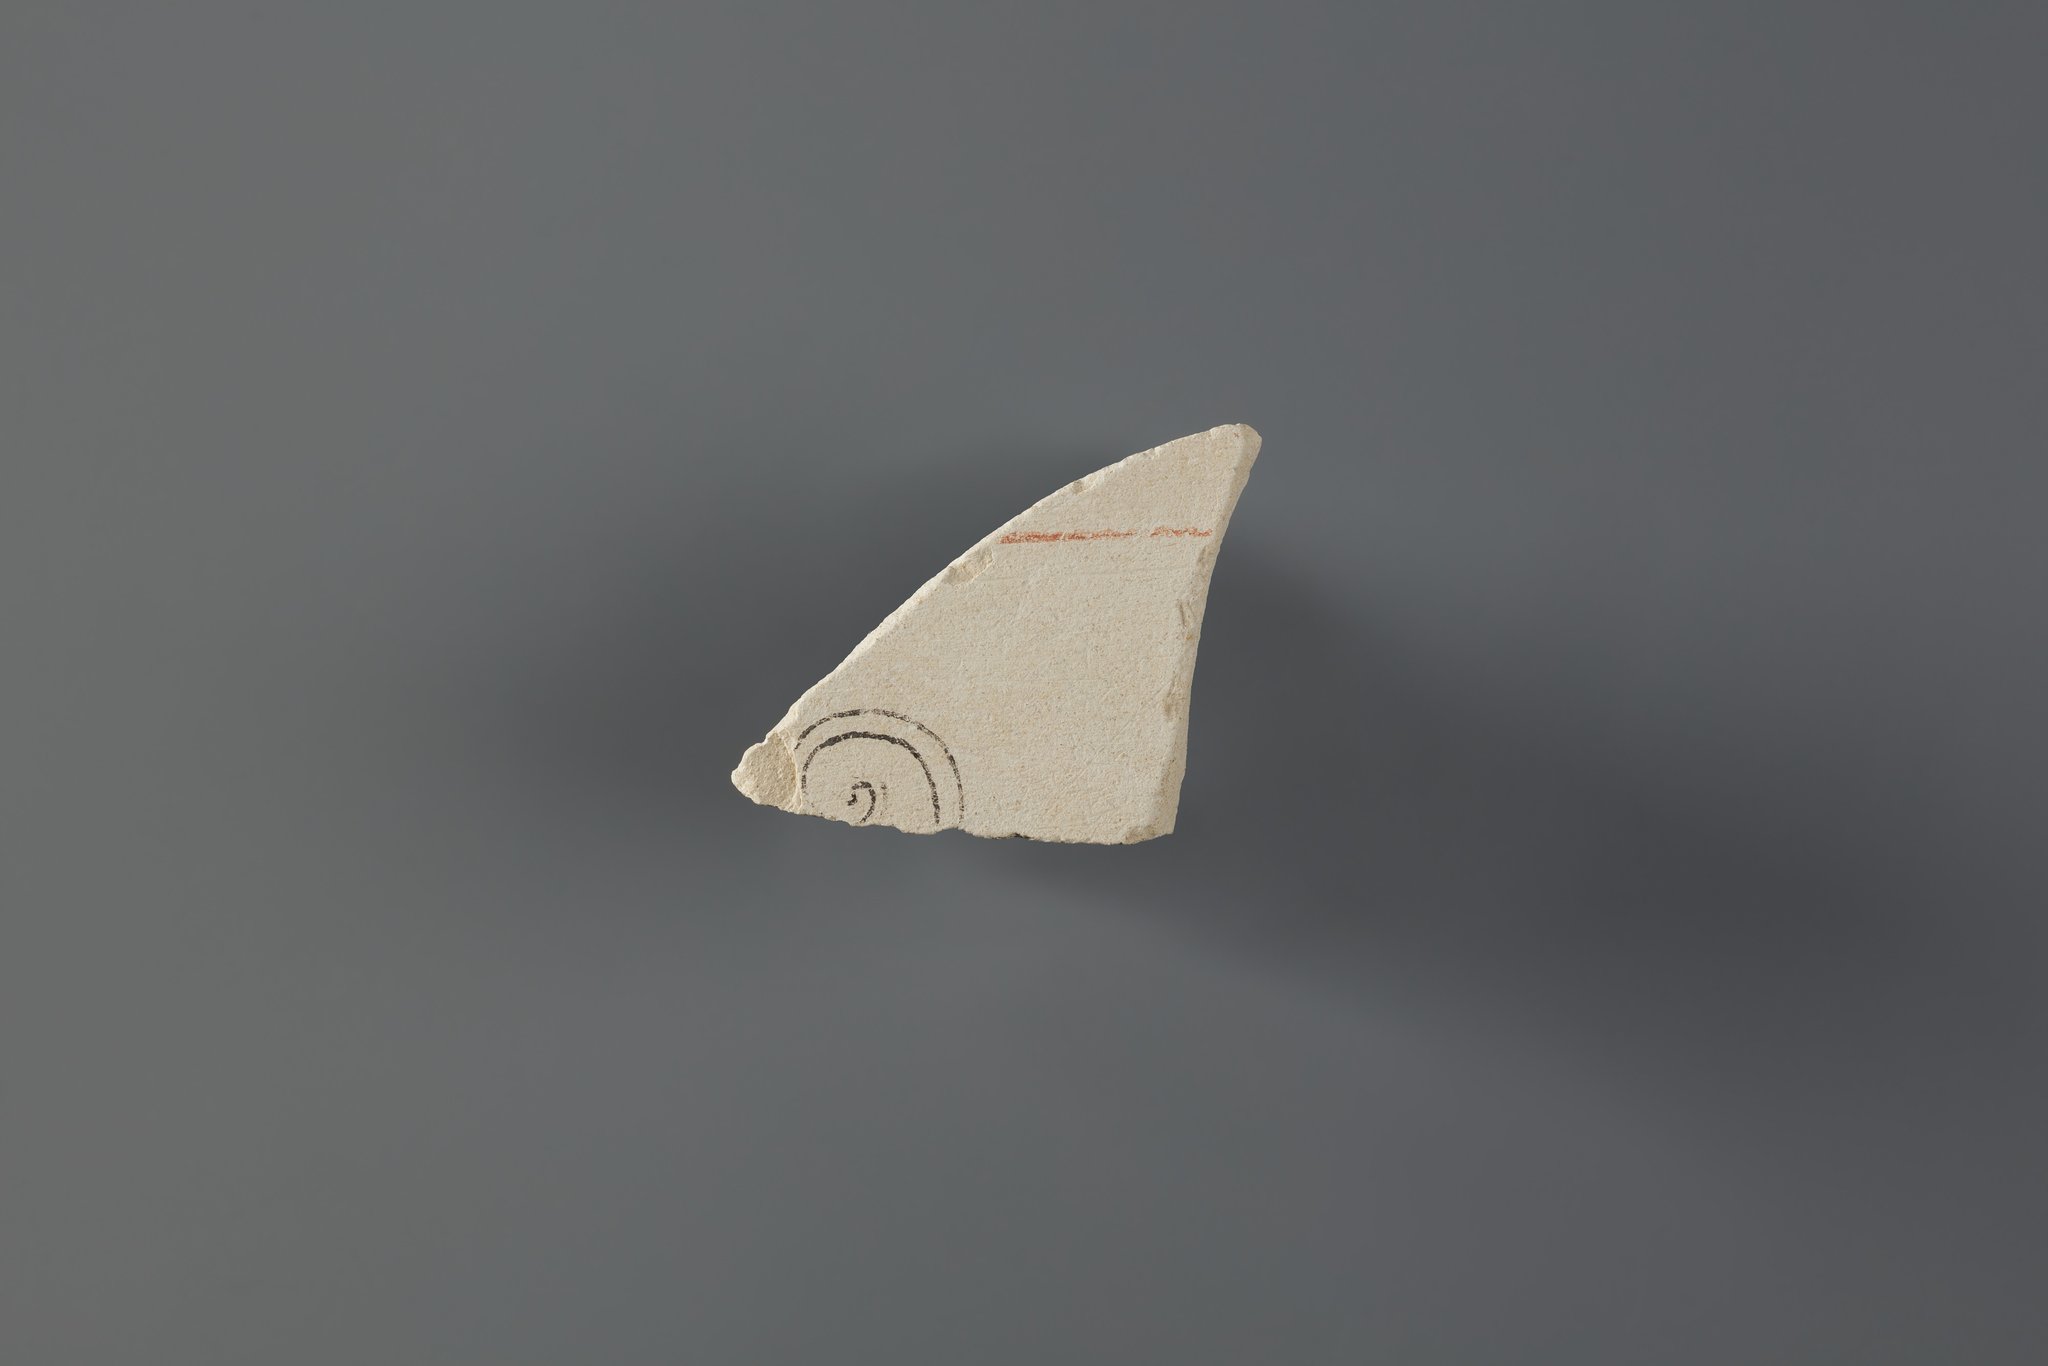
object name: relief drawing, sebeknakhte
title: Preliminary drawing for a relief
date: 2124-1504 BCE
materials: limestone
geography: egypt